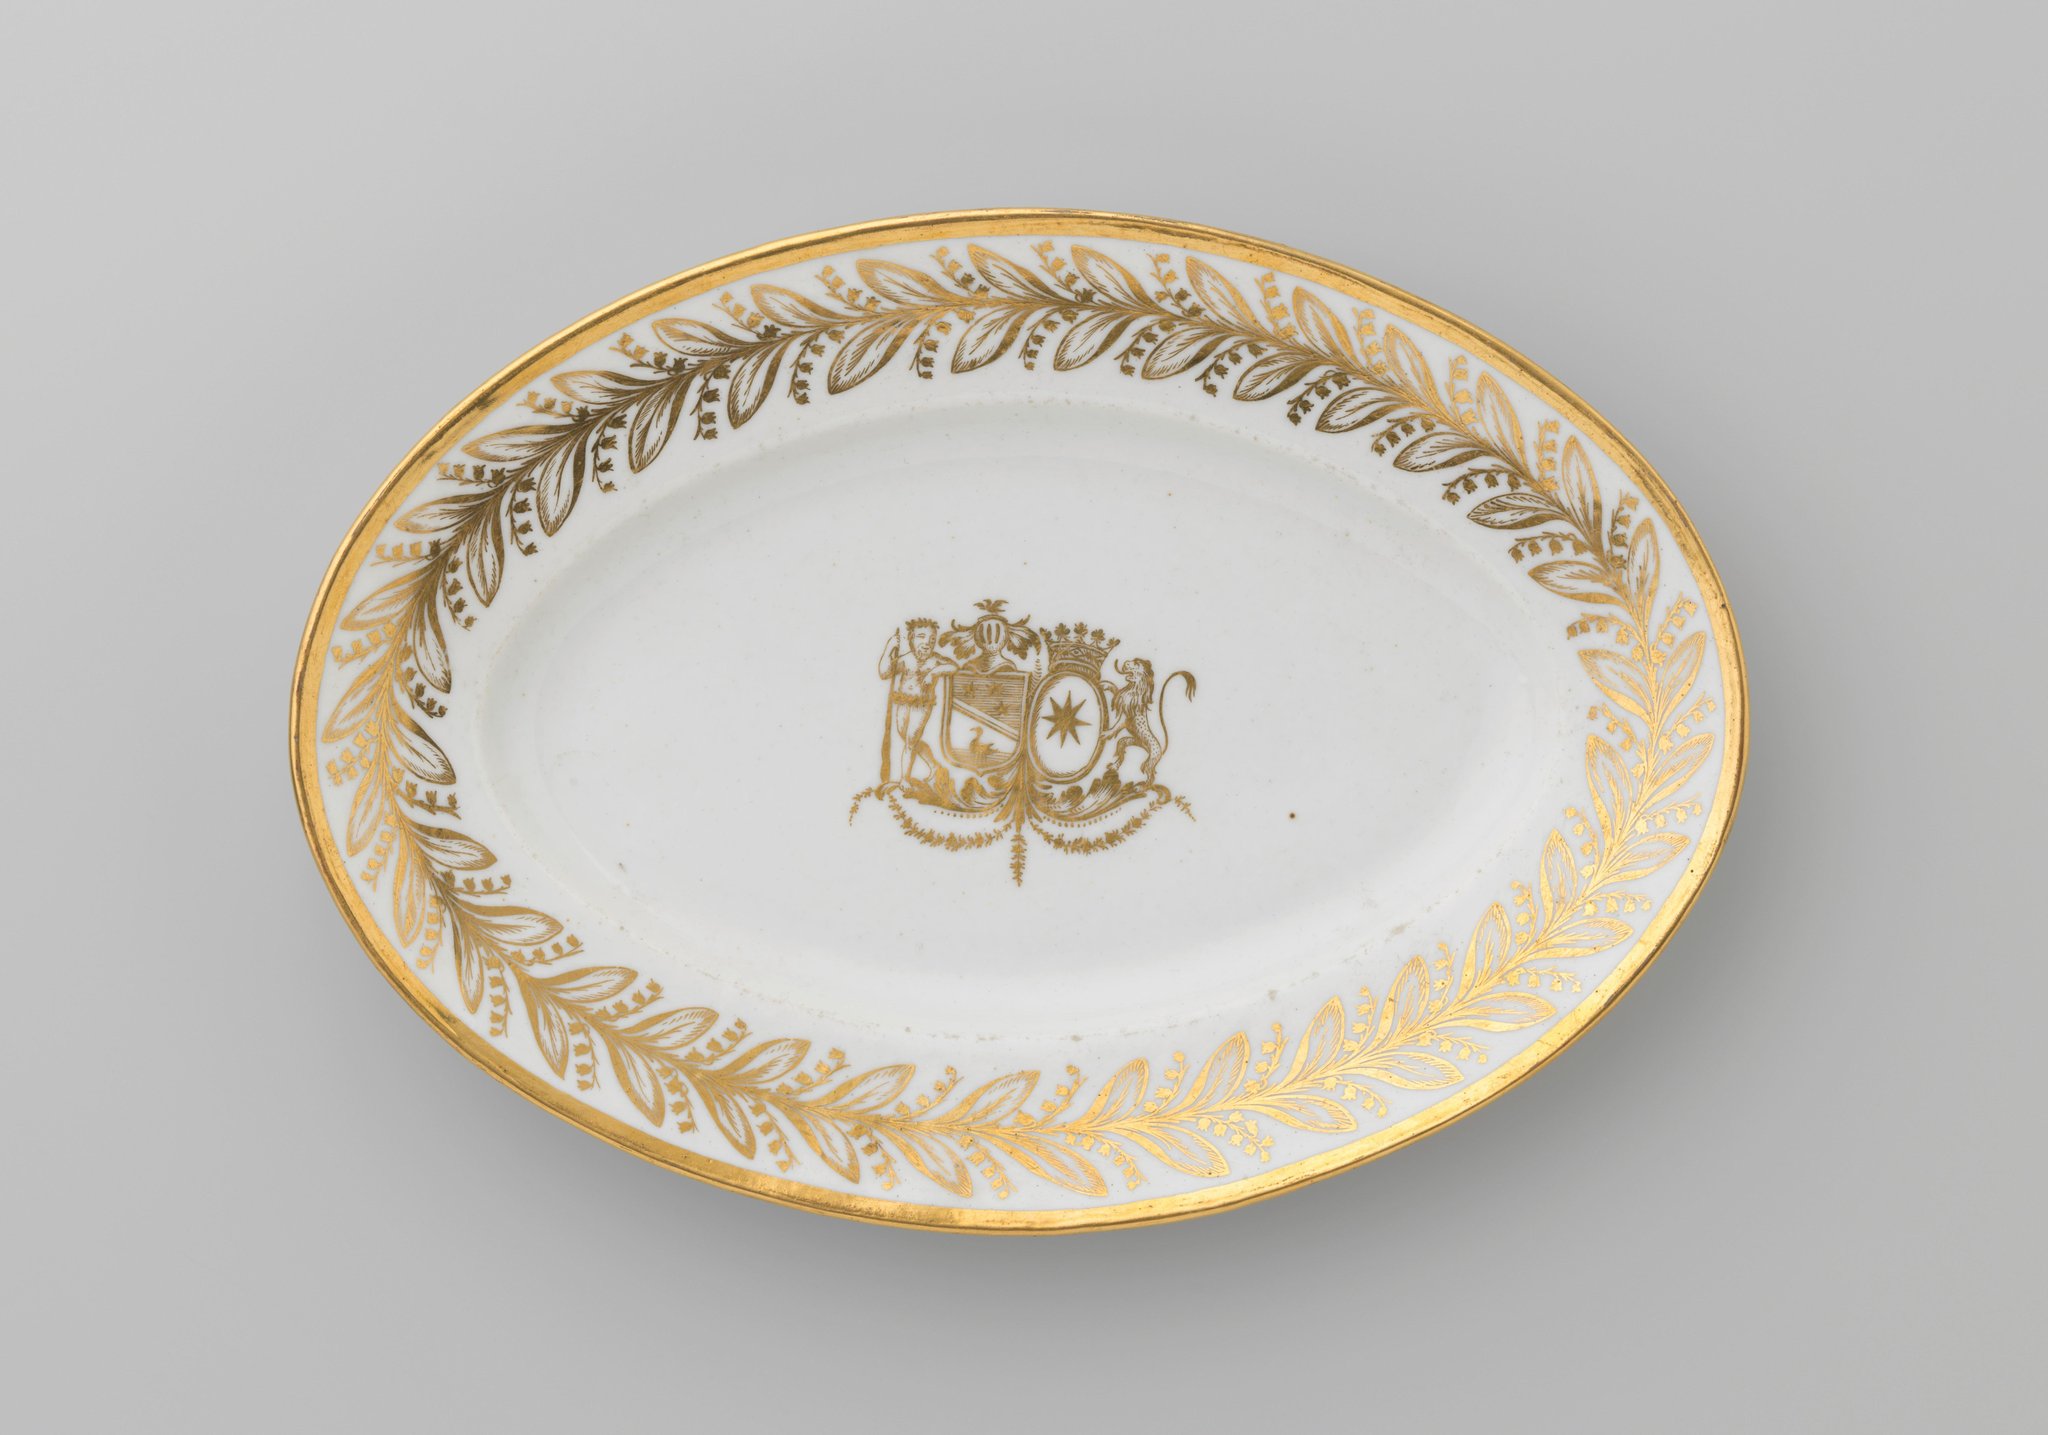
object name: service set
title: Dish with the coat of arms of Hendrik Peter Godfried Quack and Isabella Gertraud von Carnap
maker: Anonymous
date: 1790-1800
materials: glaze, gold, paint, porcelain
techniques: firing, forming, gilding, turning, vitrification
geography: netherlands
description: Ovale schotel van porselein, beschilderd op het glazuur met goud. Op het plat het alliantiewapen van Hendrik Peter Godfried Quack en Isabella Gertraud von Carnap. De rand met een bloemrank en een gouden band. Vier proenen op de onderzijde.